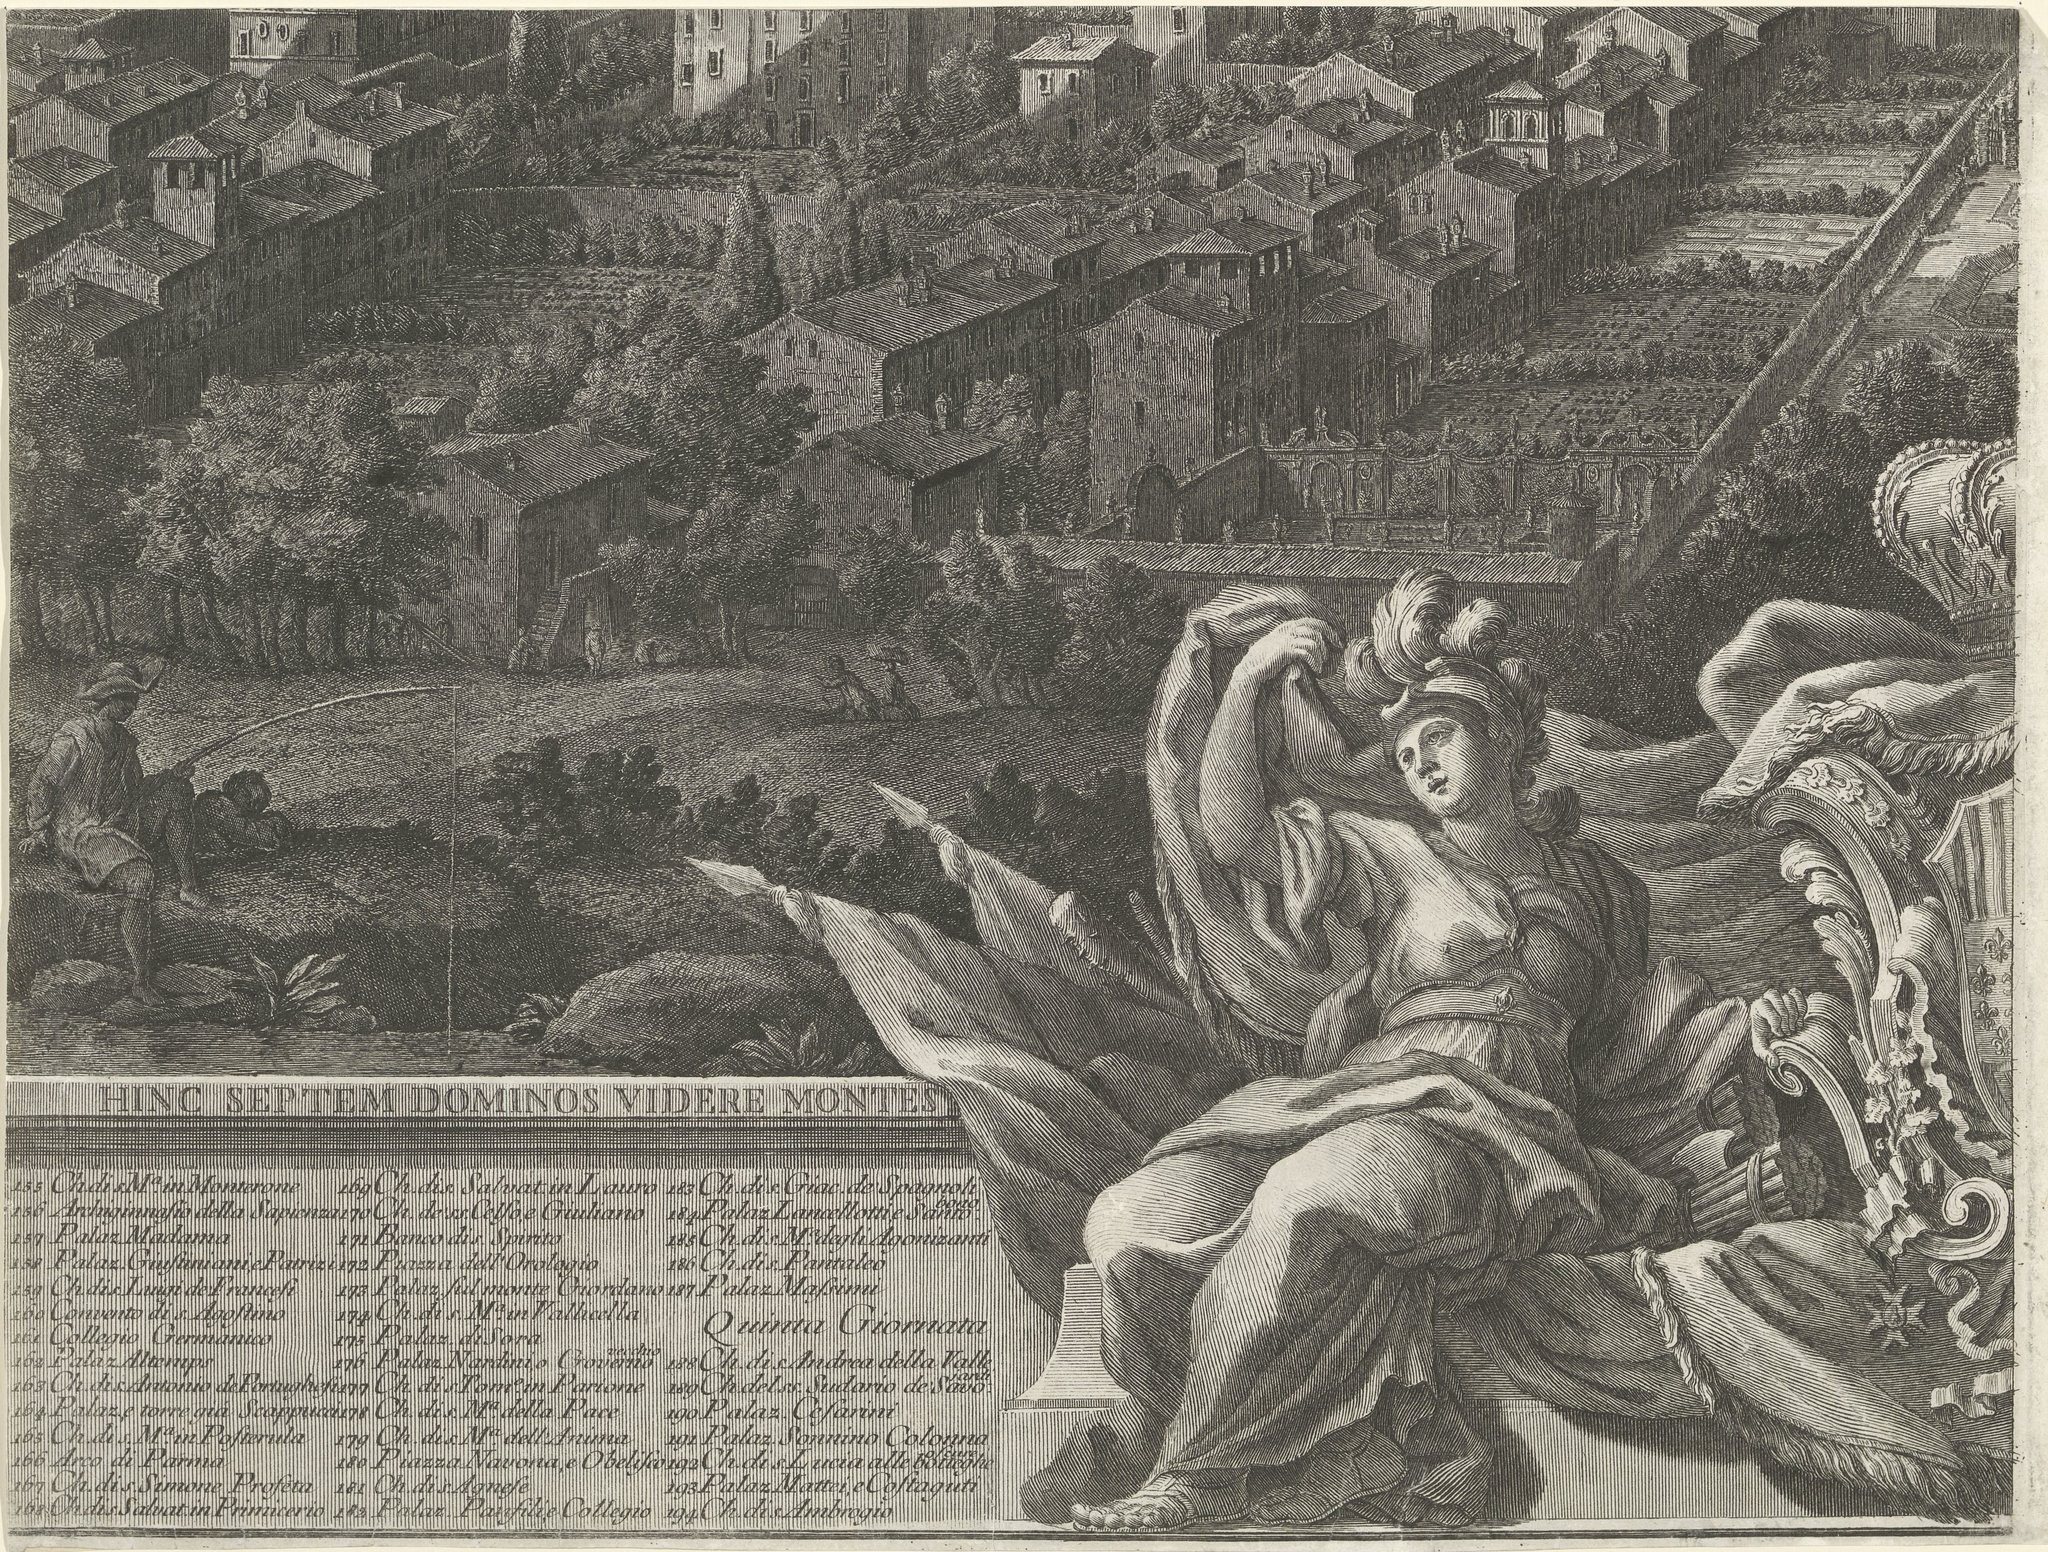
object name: print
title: Panorama van de stad Rome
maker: giuseppe vasi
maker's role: draughtsman, painter, print maker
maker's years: 1710-1782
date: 1765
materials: paper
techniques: etching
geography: rome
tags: panorama, cyclorama, city-view in general; 'veduta', rome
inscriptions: collector's mark: Lugt 2228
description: Deel van een panorama van de stad Rome, gezien vanaf de Janiculum heuvel. Verklarende lijst met nummers in ondermarge.